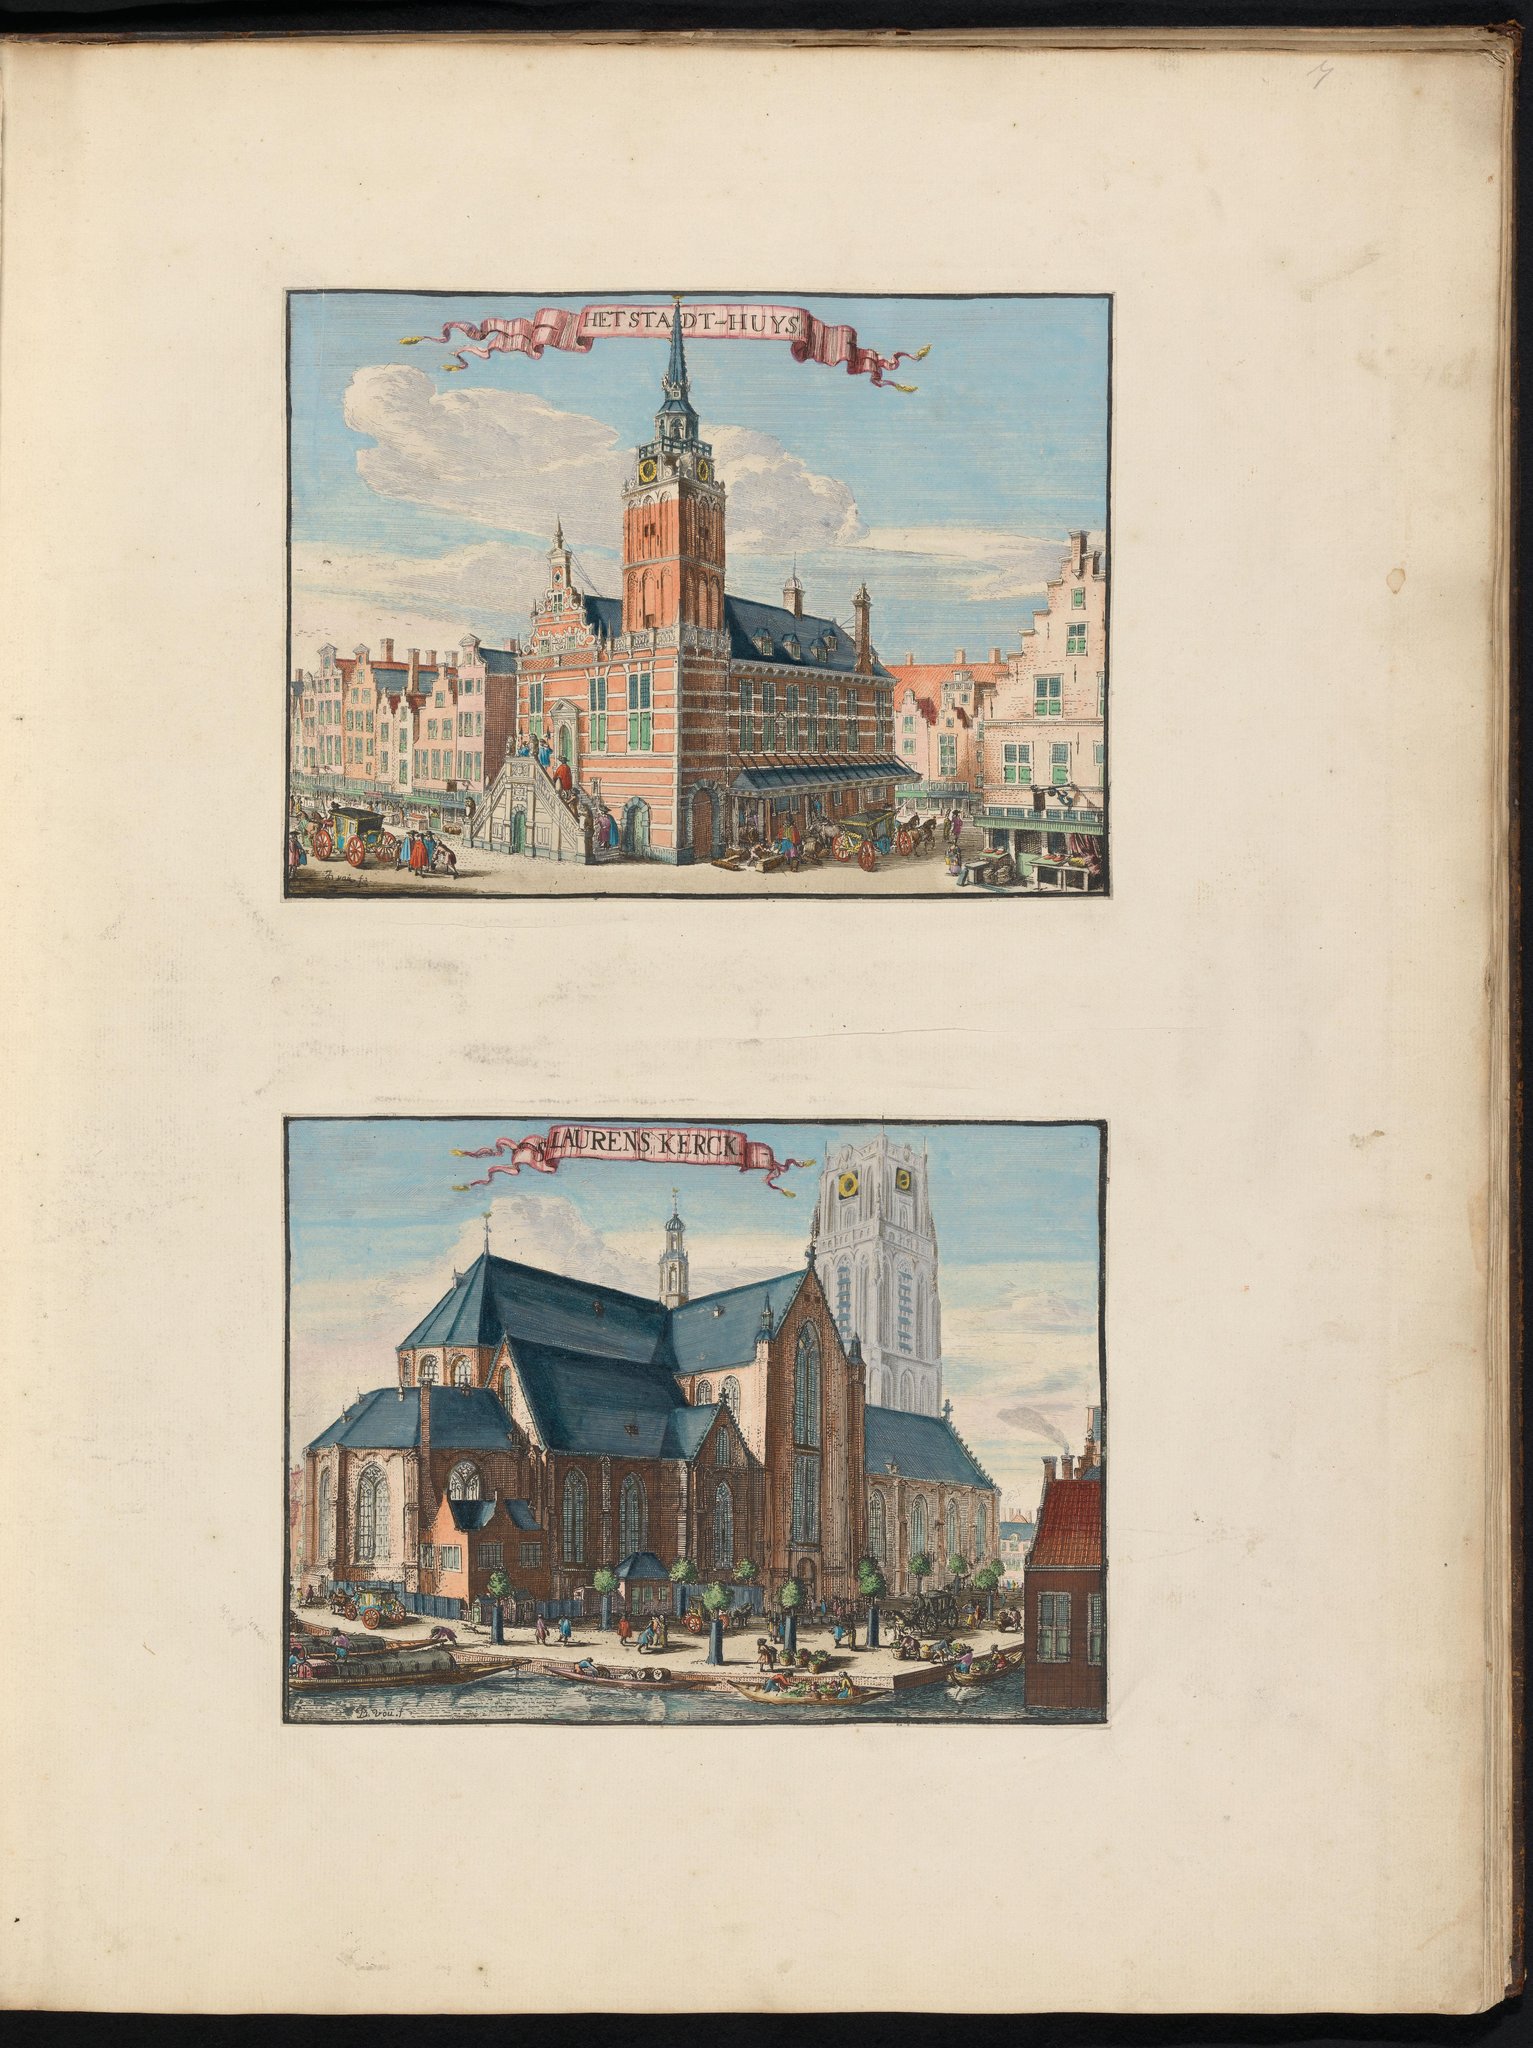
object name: album leaf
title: Caart van de stad Rotterdam (...)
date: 1694-1695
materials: paper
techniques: colour, etching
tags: rotterdam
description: Twee voorstellingen op een albumblad. Boven een gezicht op het stadhuis van Rotterdam aan de Hoogstraat. Onder een gezicht op de Sint-Laurenskerk aan het Grote Kerkplein. Rechtsboven de letters A en B. De prenten zijn onderdeel van de kaart van Rotterdam door Johannes de Vouw en maken deel uit van een album.